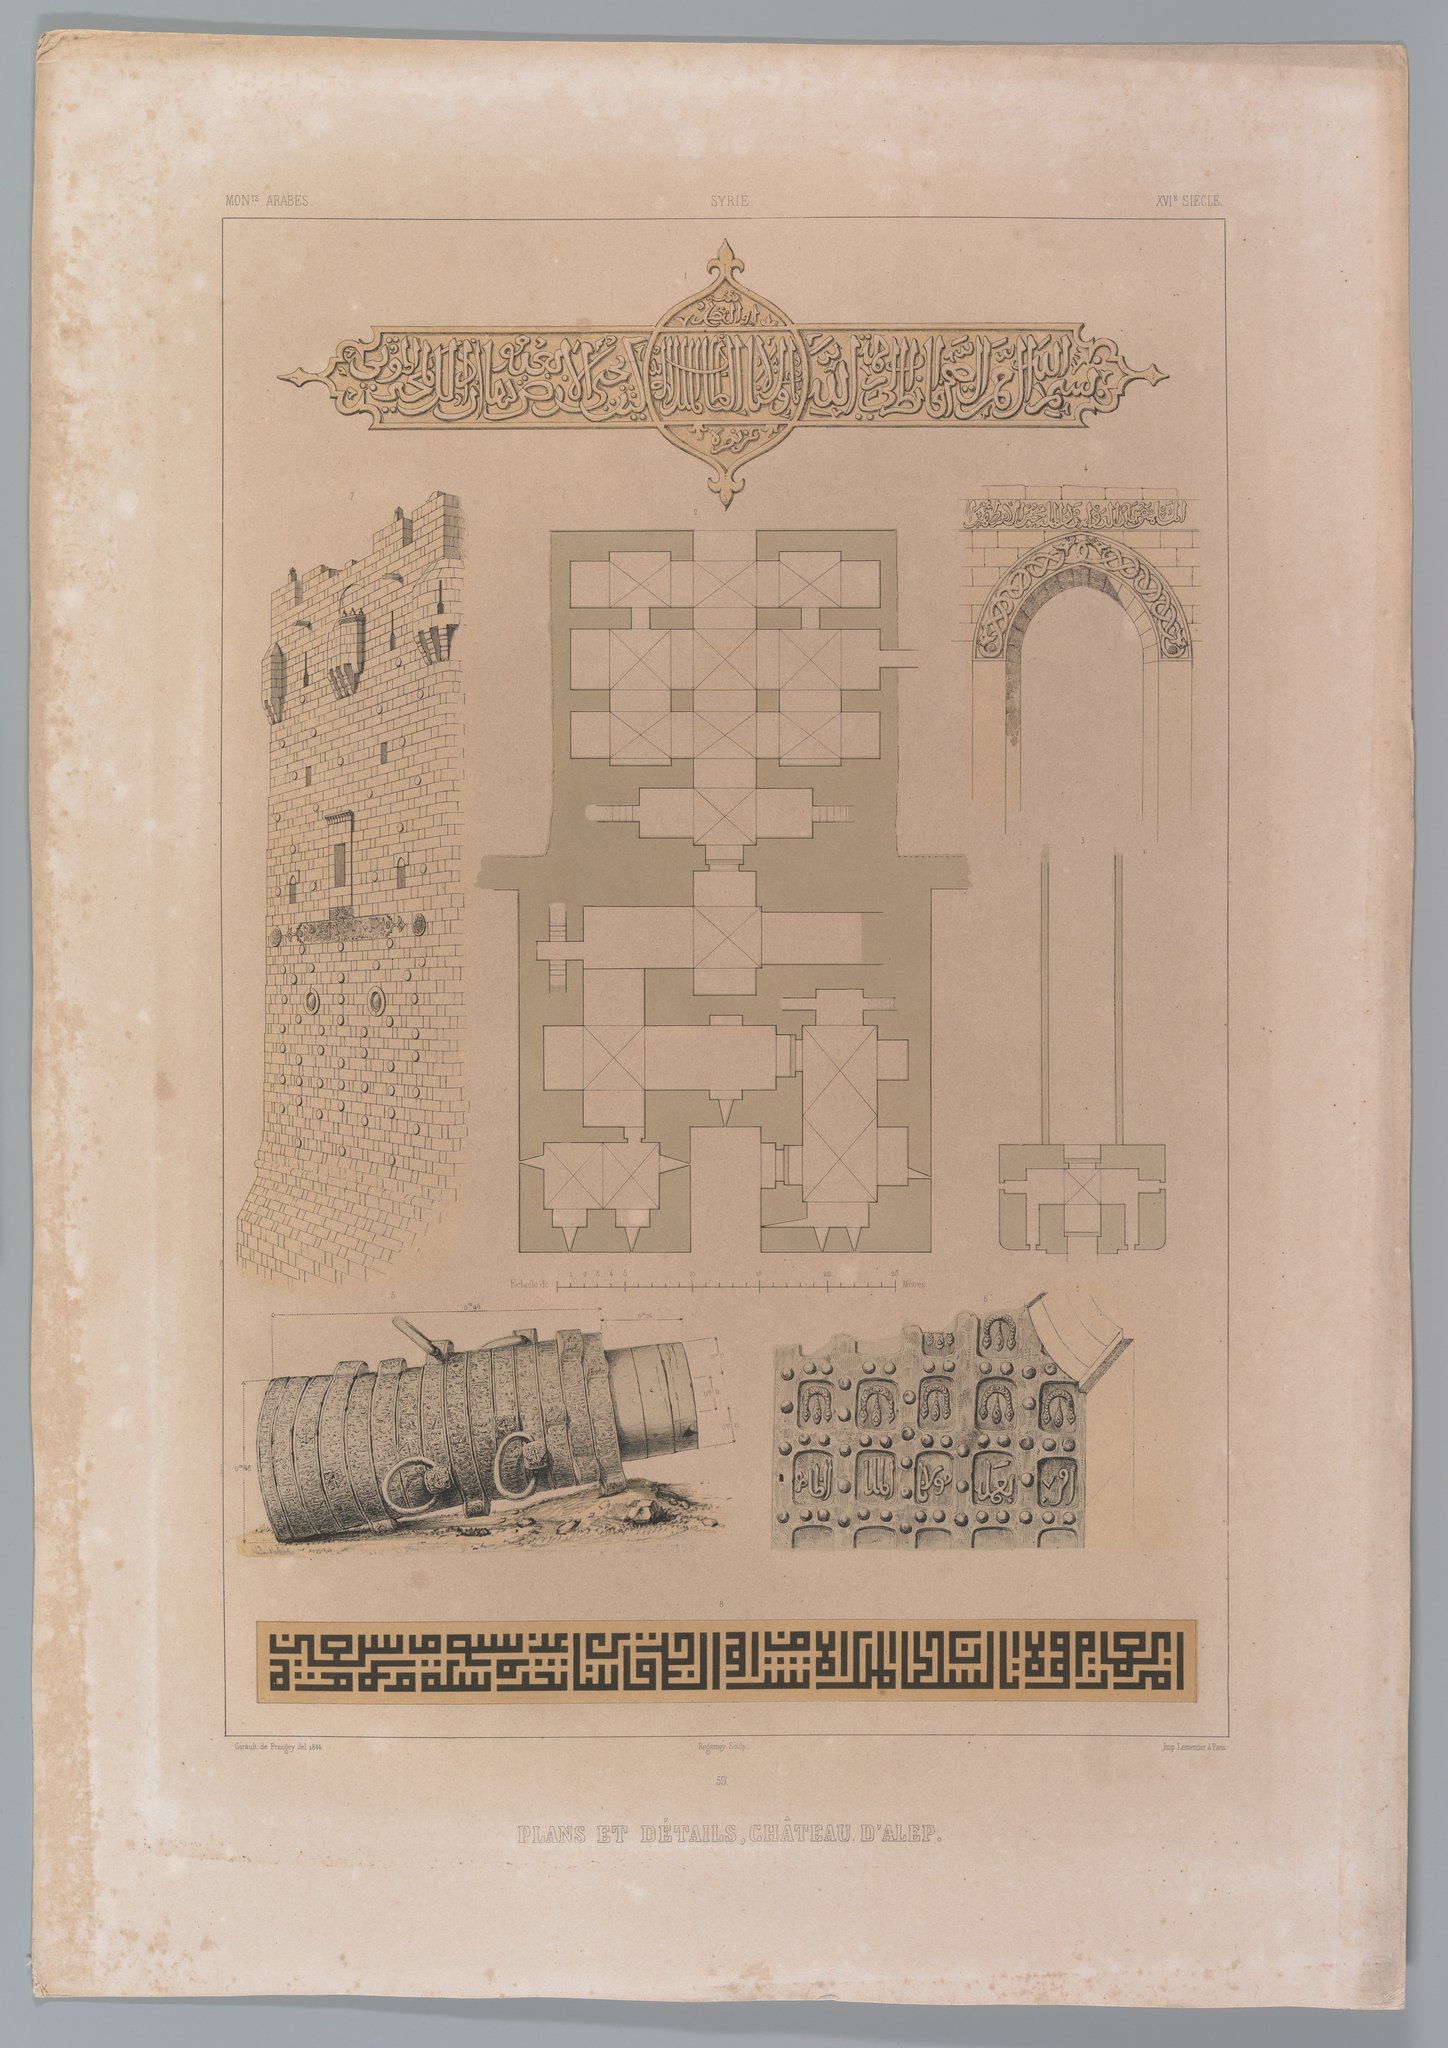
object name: lithograph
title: 59. Plan et details, Château d’Alep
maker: joseph-philibert girault de prangey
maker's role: artist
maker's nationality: french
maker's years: 1804-1892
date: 1843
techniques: lithograph